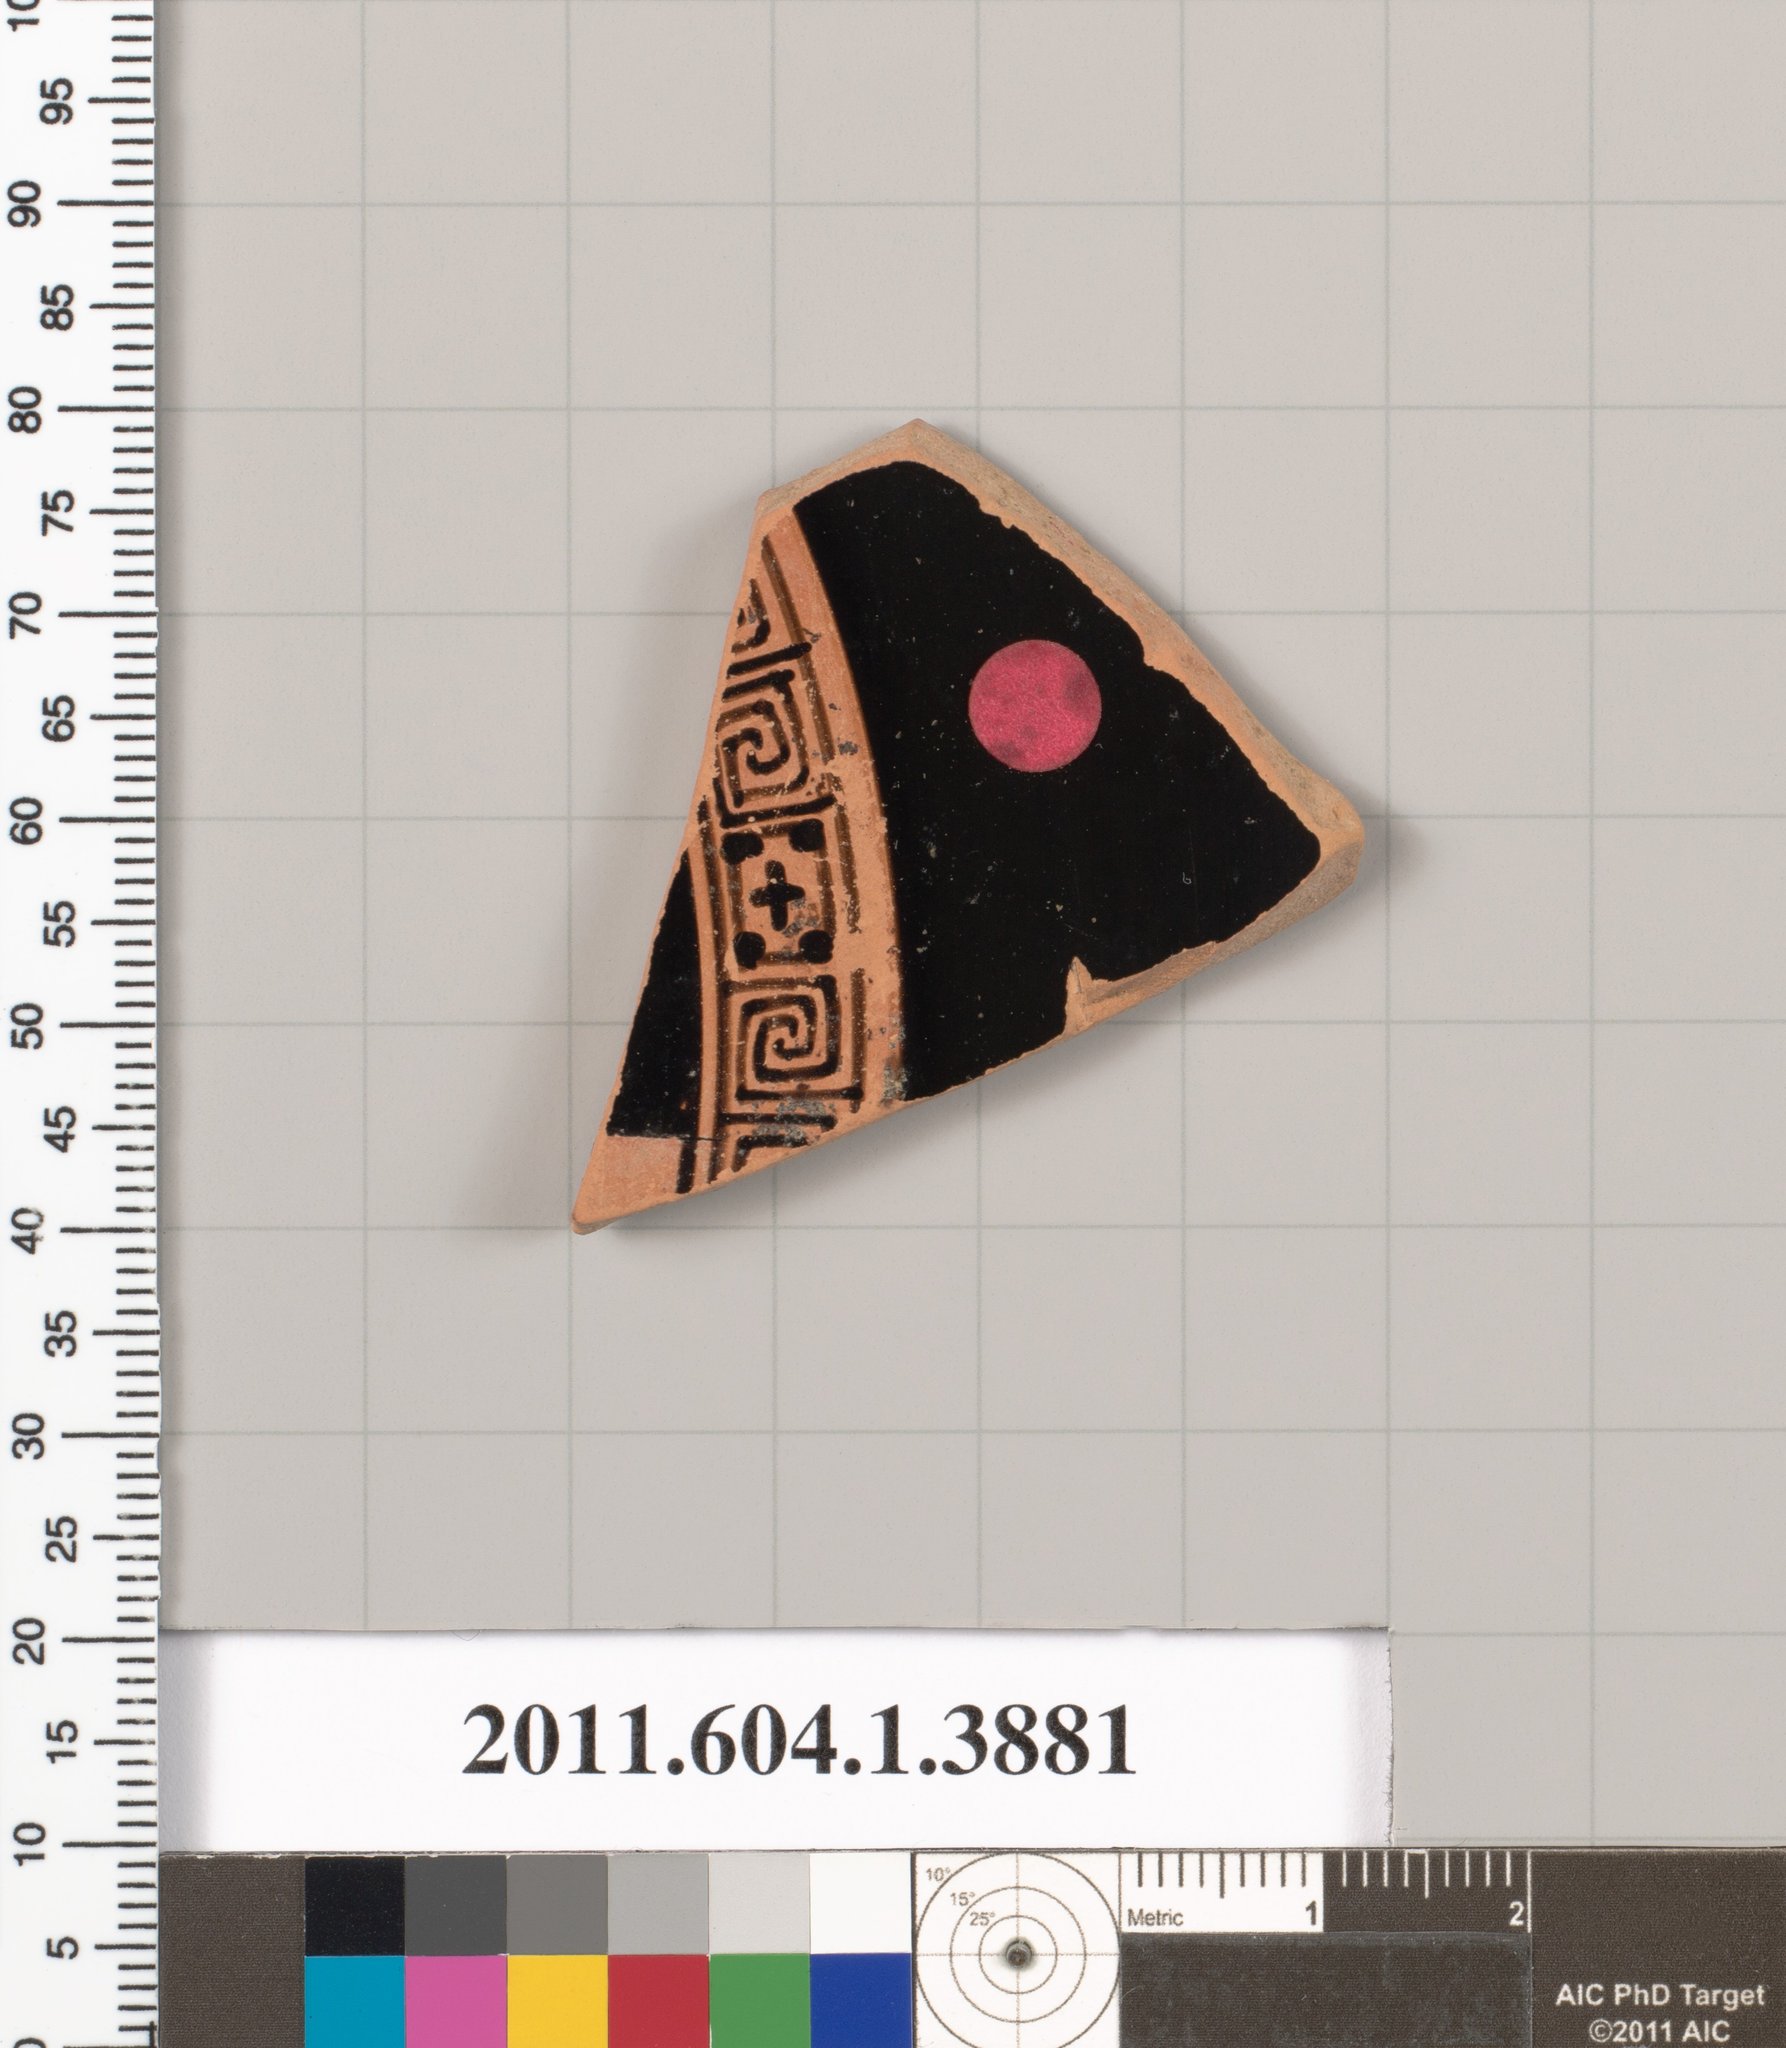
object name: kylix fragment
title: Terracotta fragment of a kylix (drinking cup)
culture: greek, attic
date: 475-451 BCE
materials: terracotta